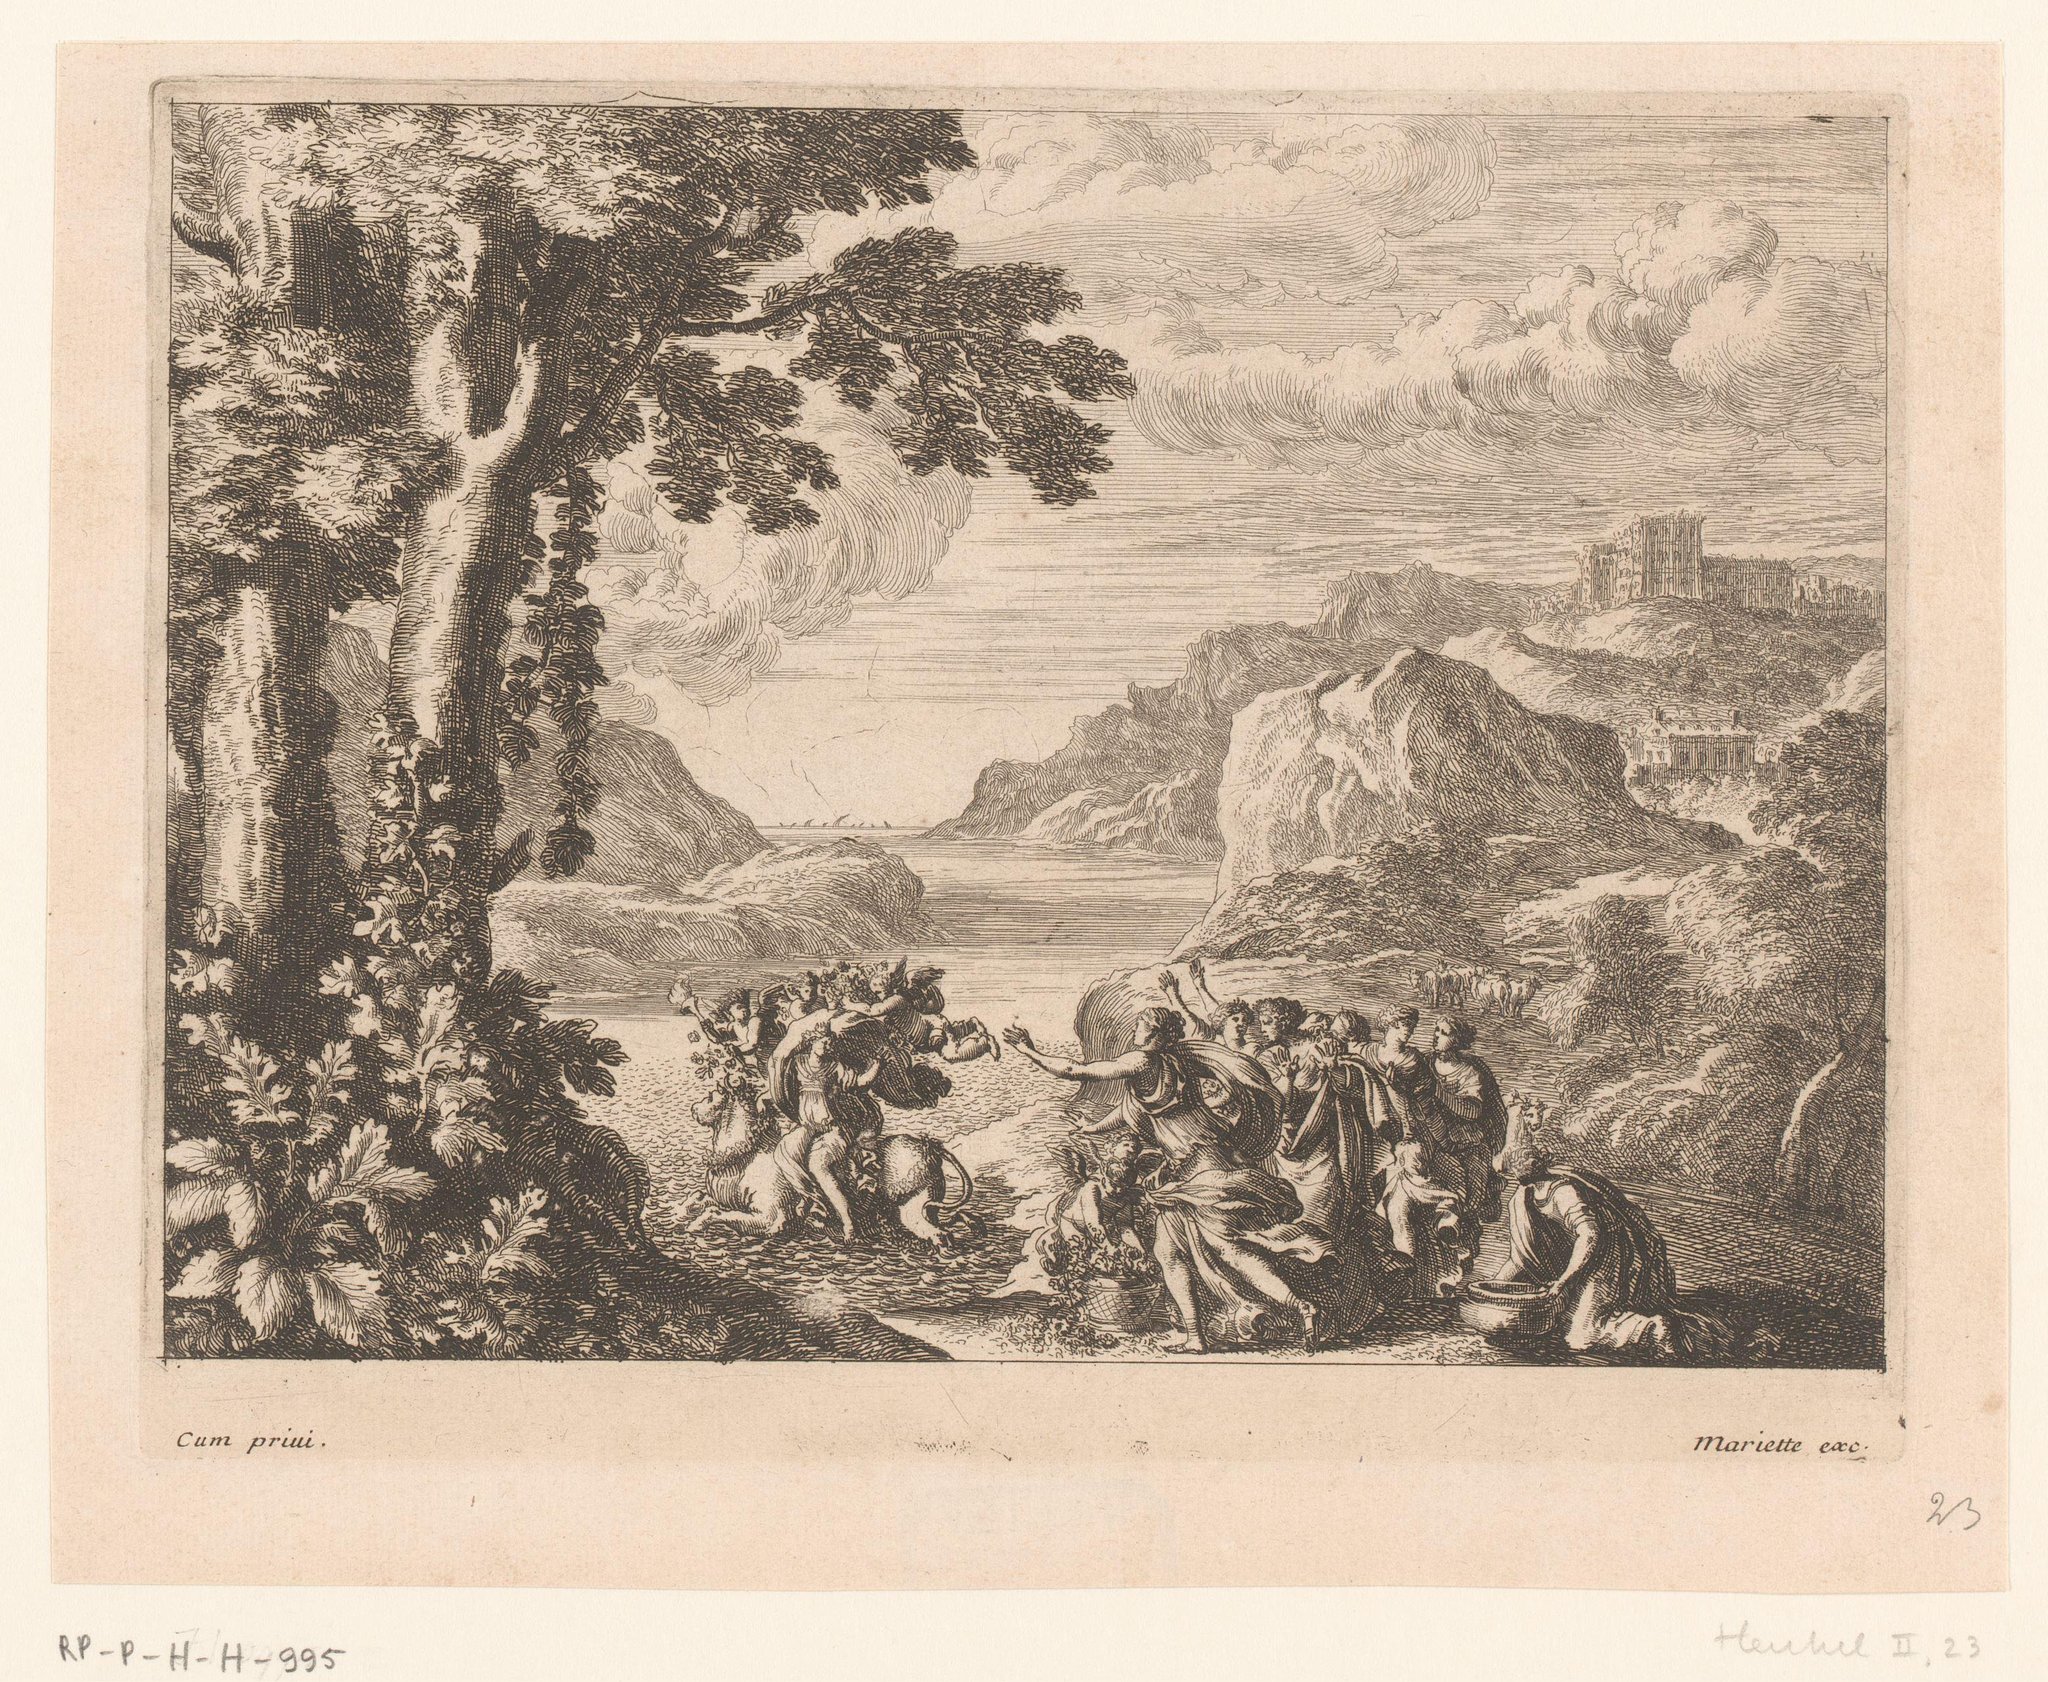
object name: print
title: Ontvoering van Europa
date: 1628-1682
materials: paper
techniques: etching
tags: jupiter, usually in the shape of a white bull, abducts europa and carries her across the water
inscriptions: collector's mark: Lugt 11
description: Maakt deel uit van een twintigdelige serie met mythologische scènes.